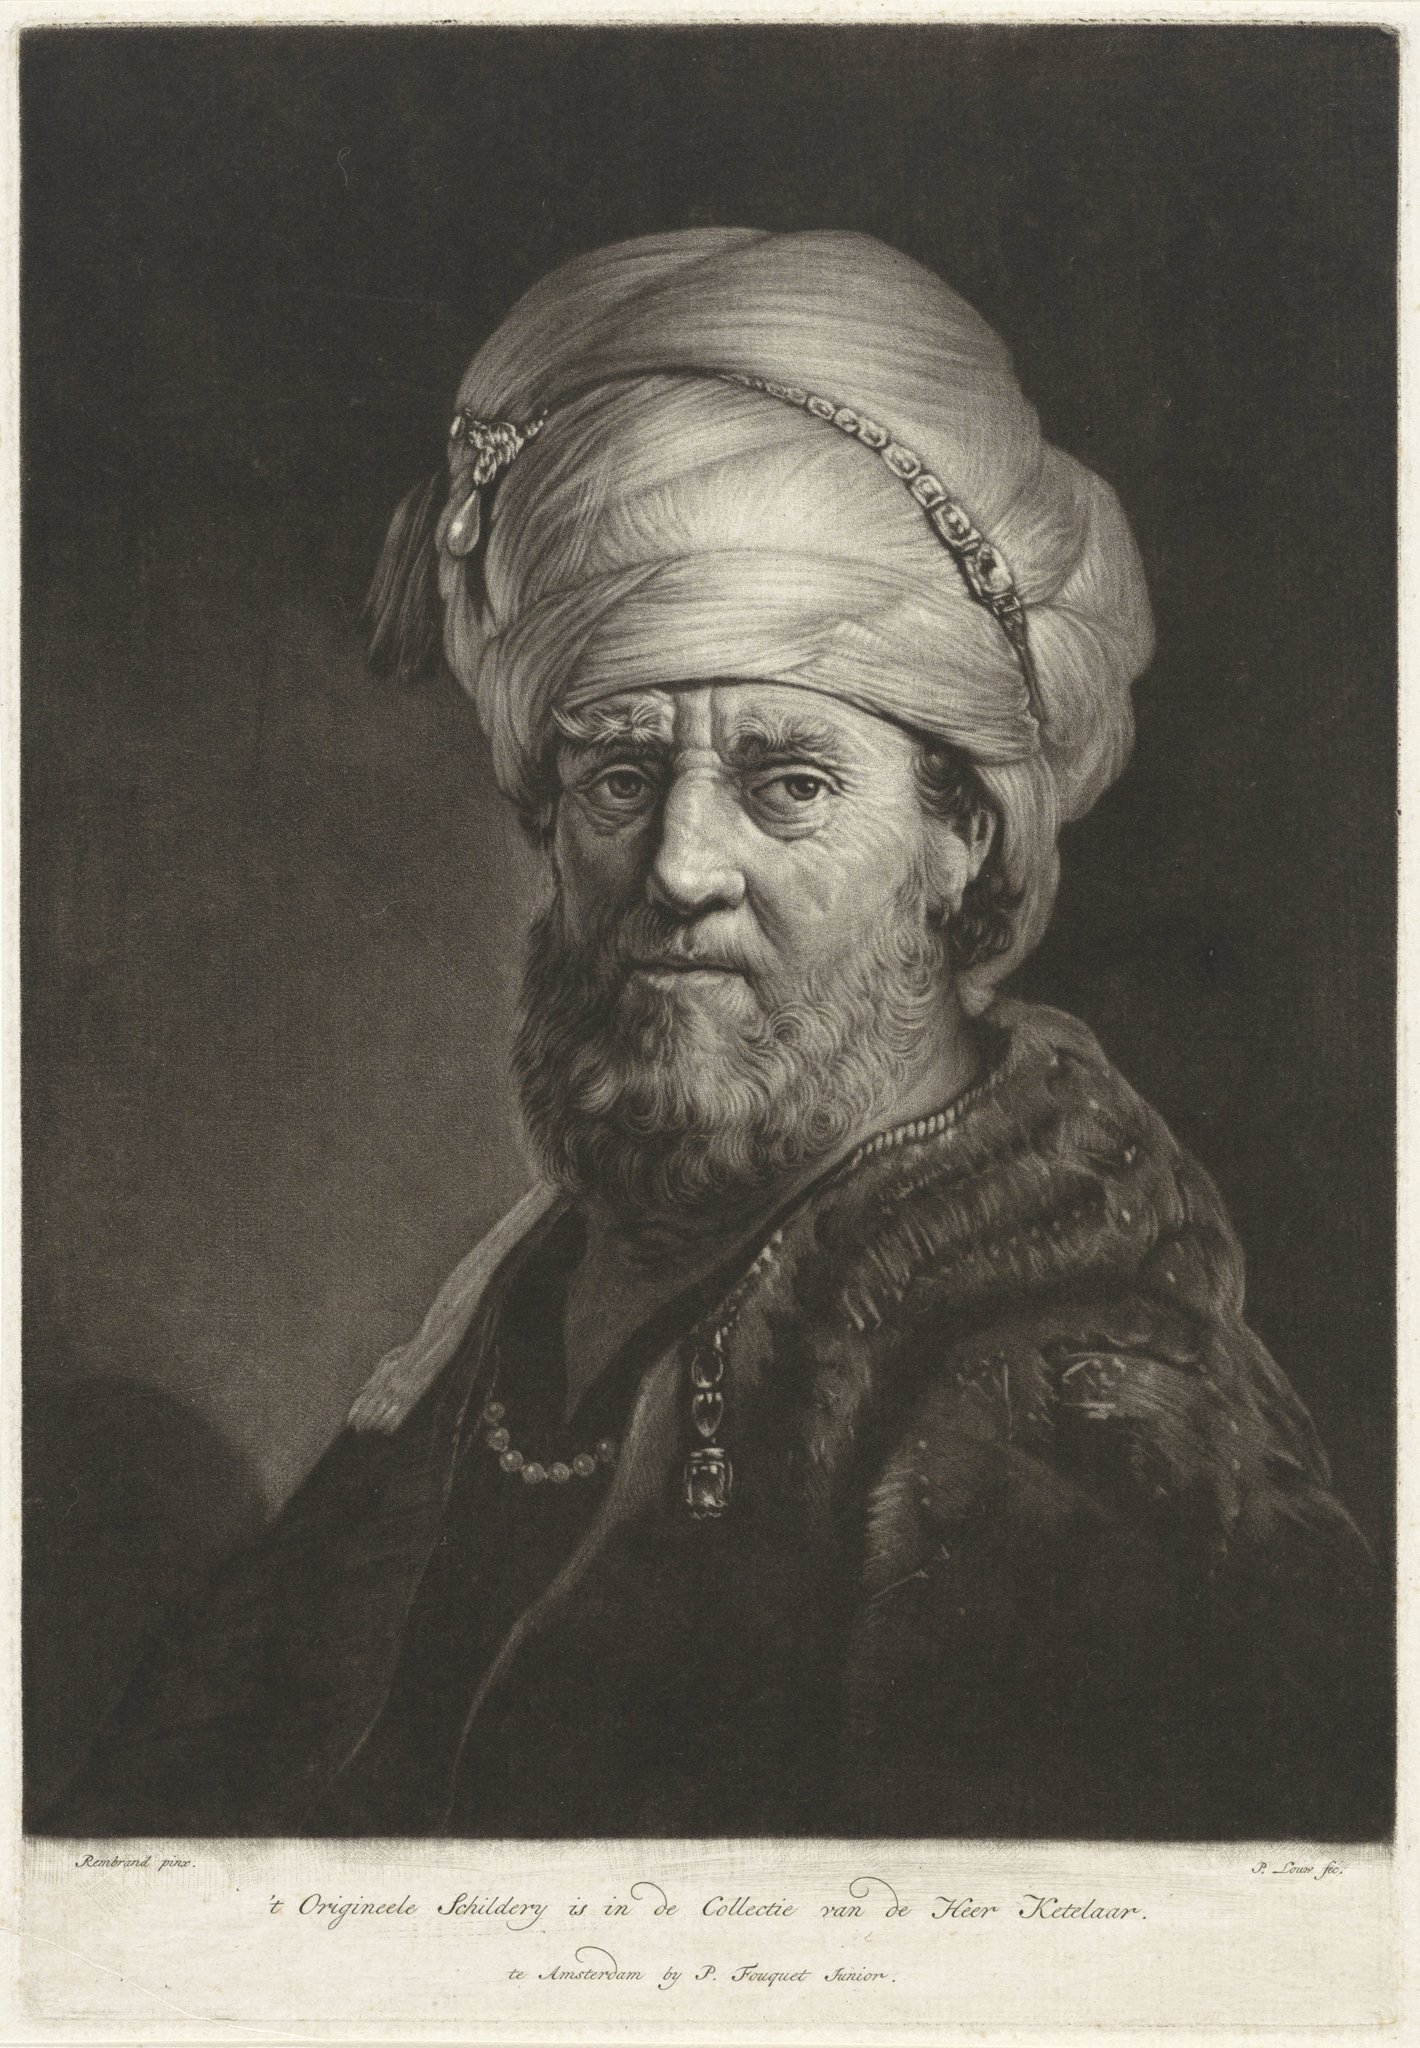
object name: print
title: Portretbuste van een man met een tulband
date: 1743-1800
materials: paper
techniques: mezzotint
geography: amsterdam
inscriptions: collector's mark: Lugt 2228